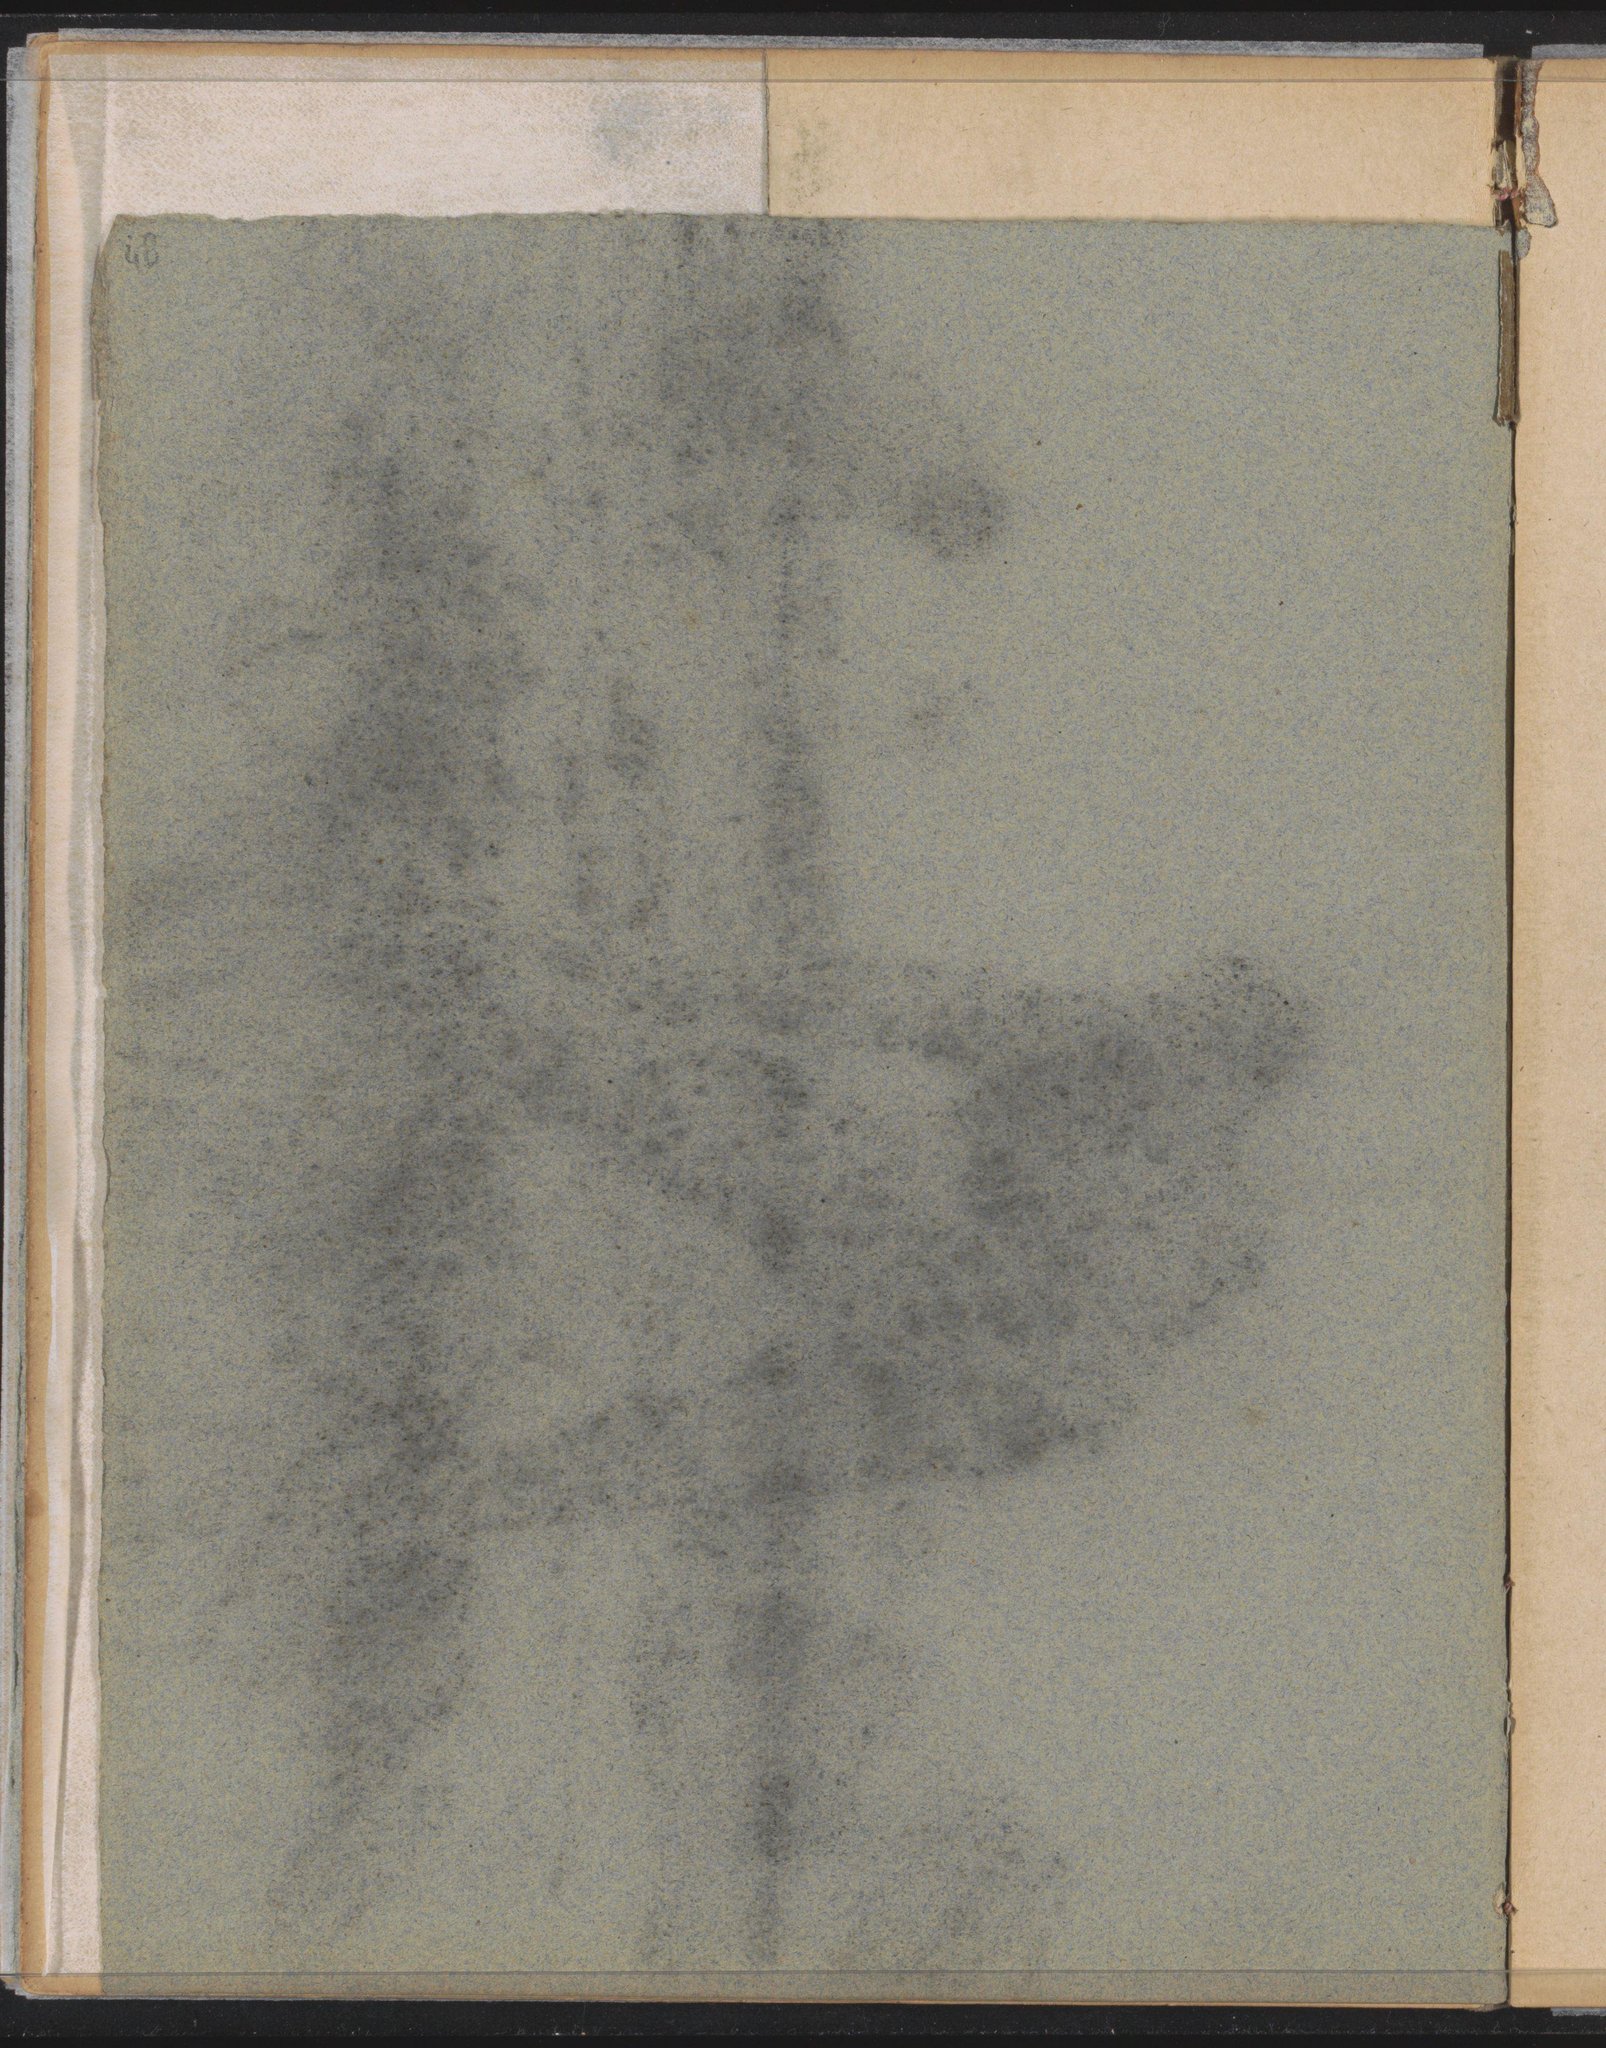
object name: sketchbook leaf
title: Abklatsch van de krijttekening op pagina 49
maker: willem witsen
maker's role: draughtsman, painter, print maker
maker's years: 1860-1923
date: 1884-1891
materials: paper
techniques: printmaking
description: Pagina 48 uit een schetsboek met 49 bladen.